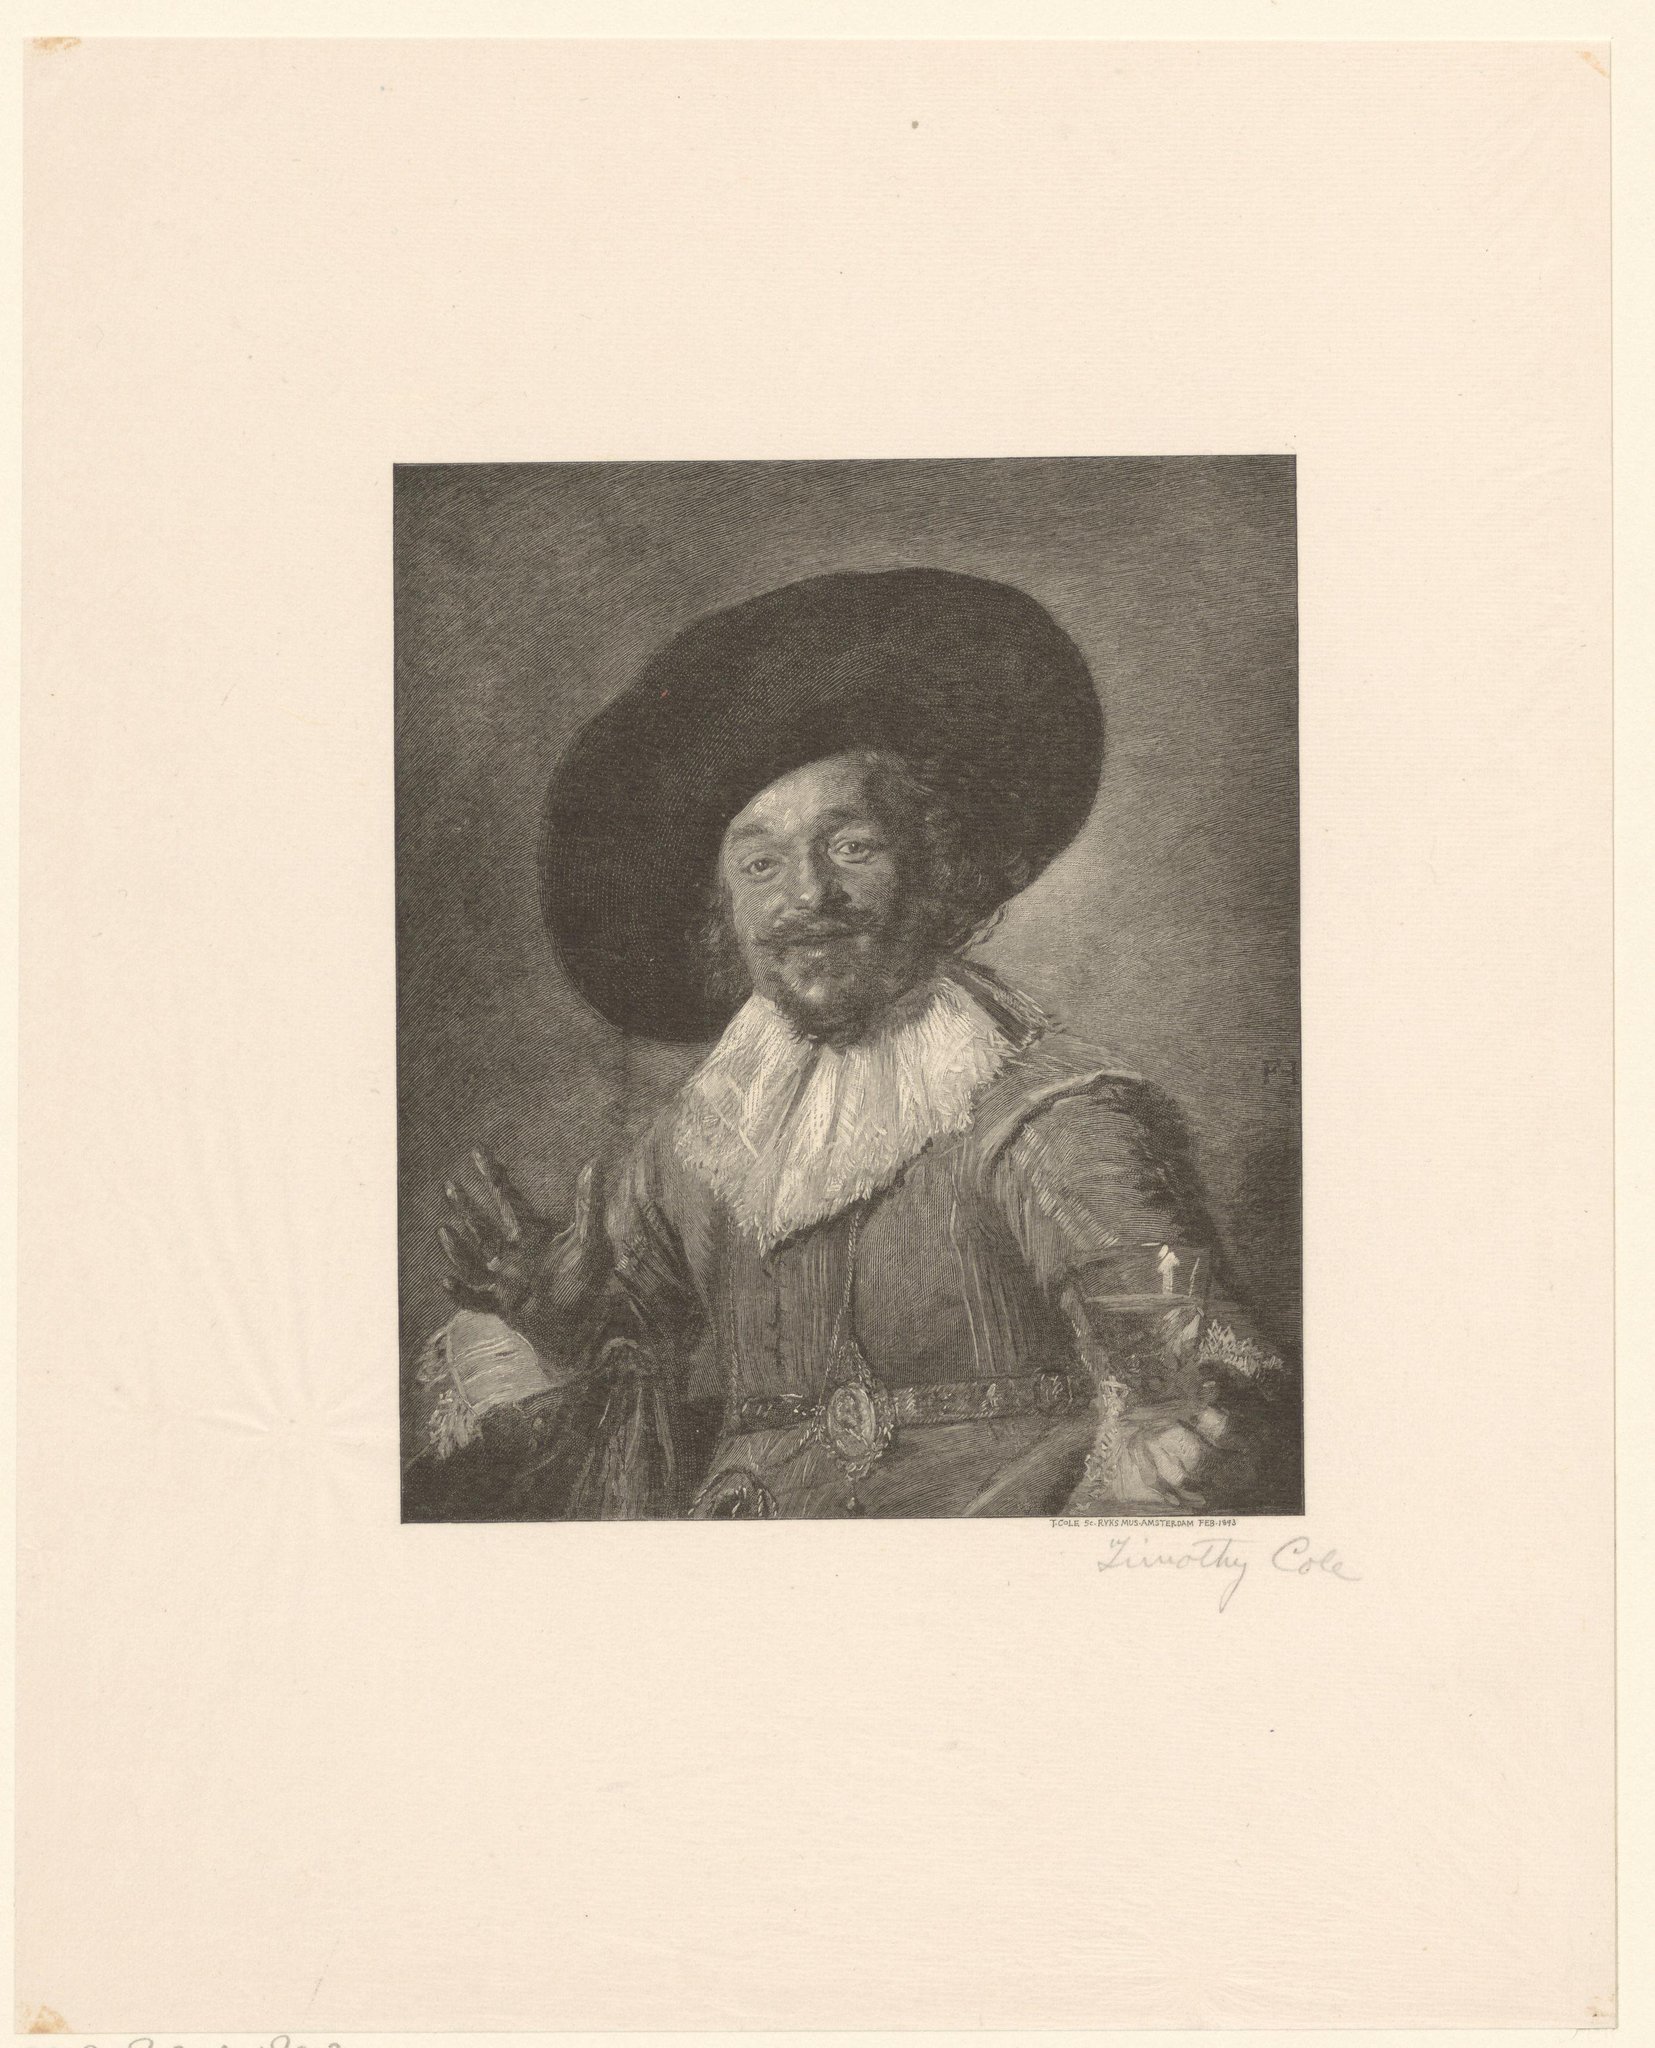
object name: print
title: De vrolijke drinker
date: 1893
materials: paper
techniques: engraving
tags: head-gear, adult man, drinking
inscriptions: collector's mark: Lugt 2228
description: Prent mogelijk uit: The Century Magazine, januari 1894.